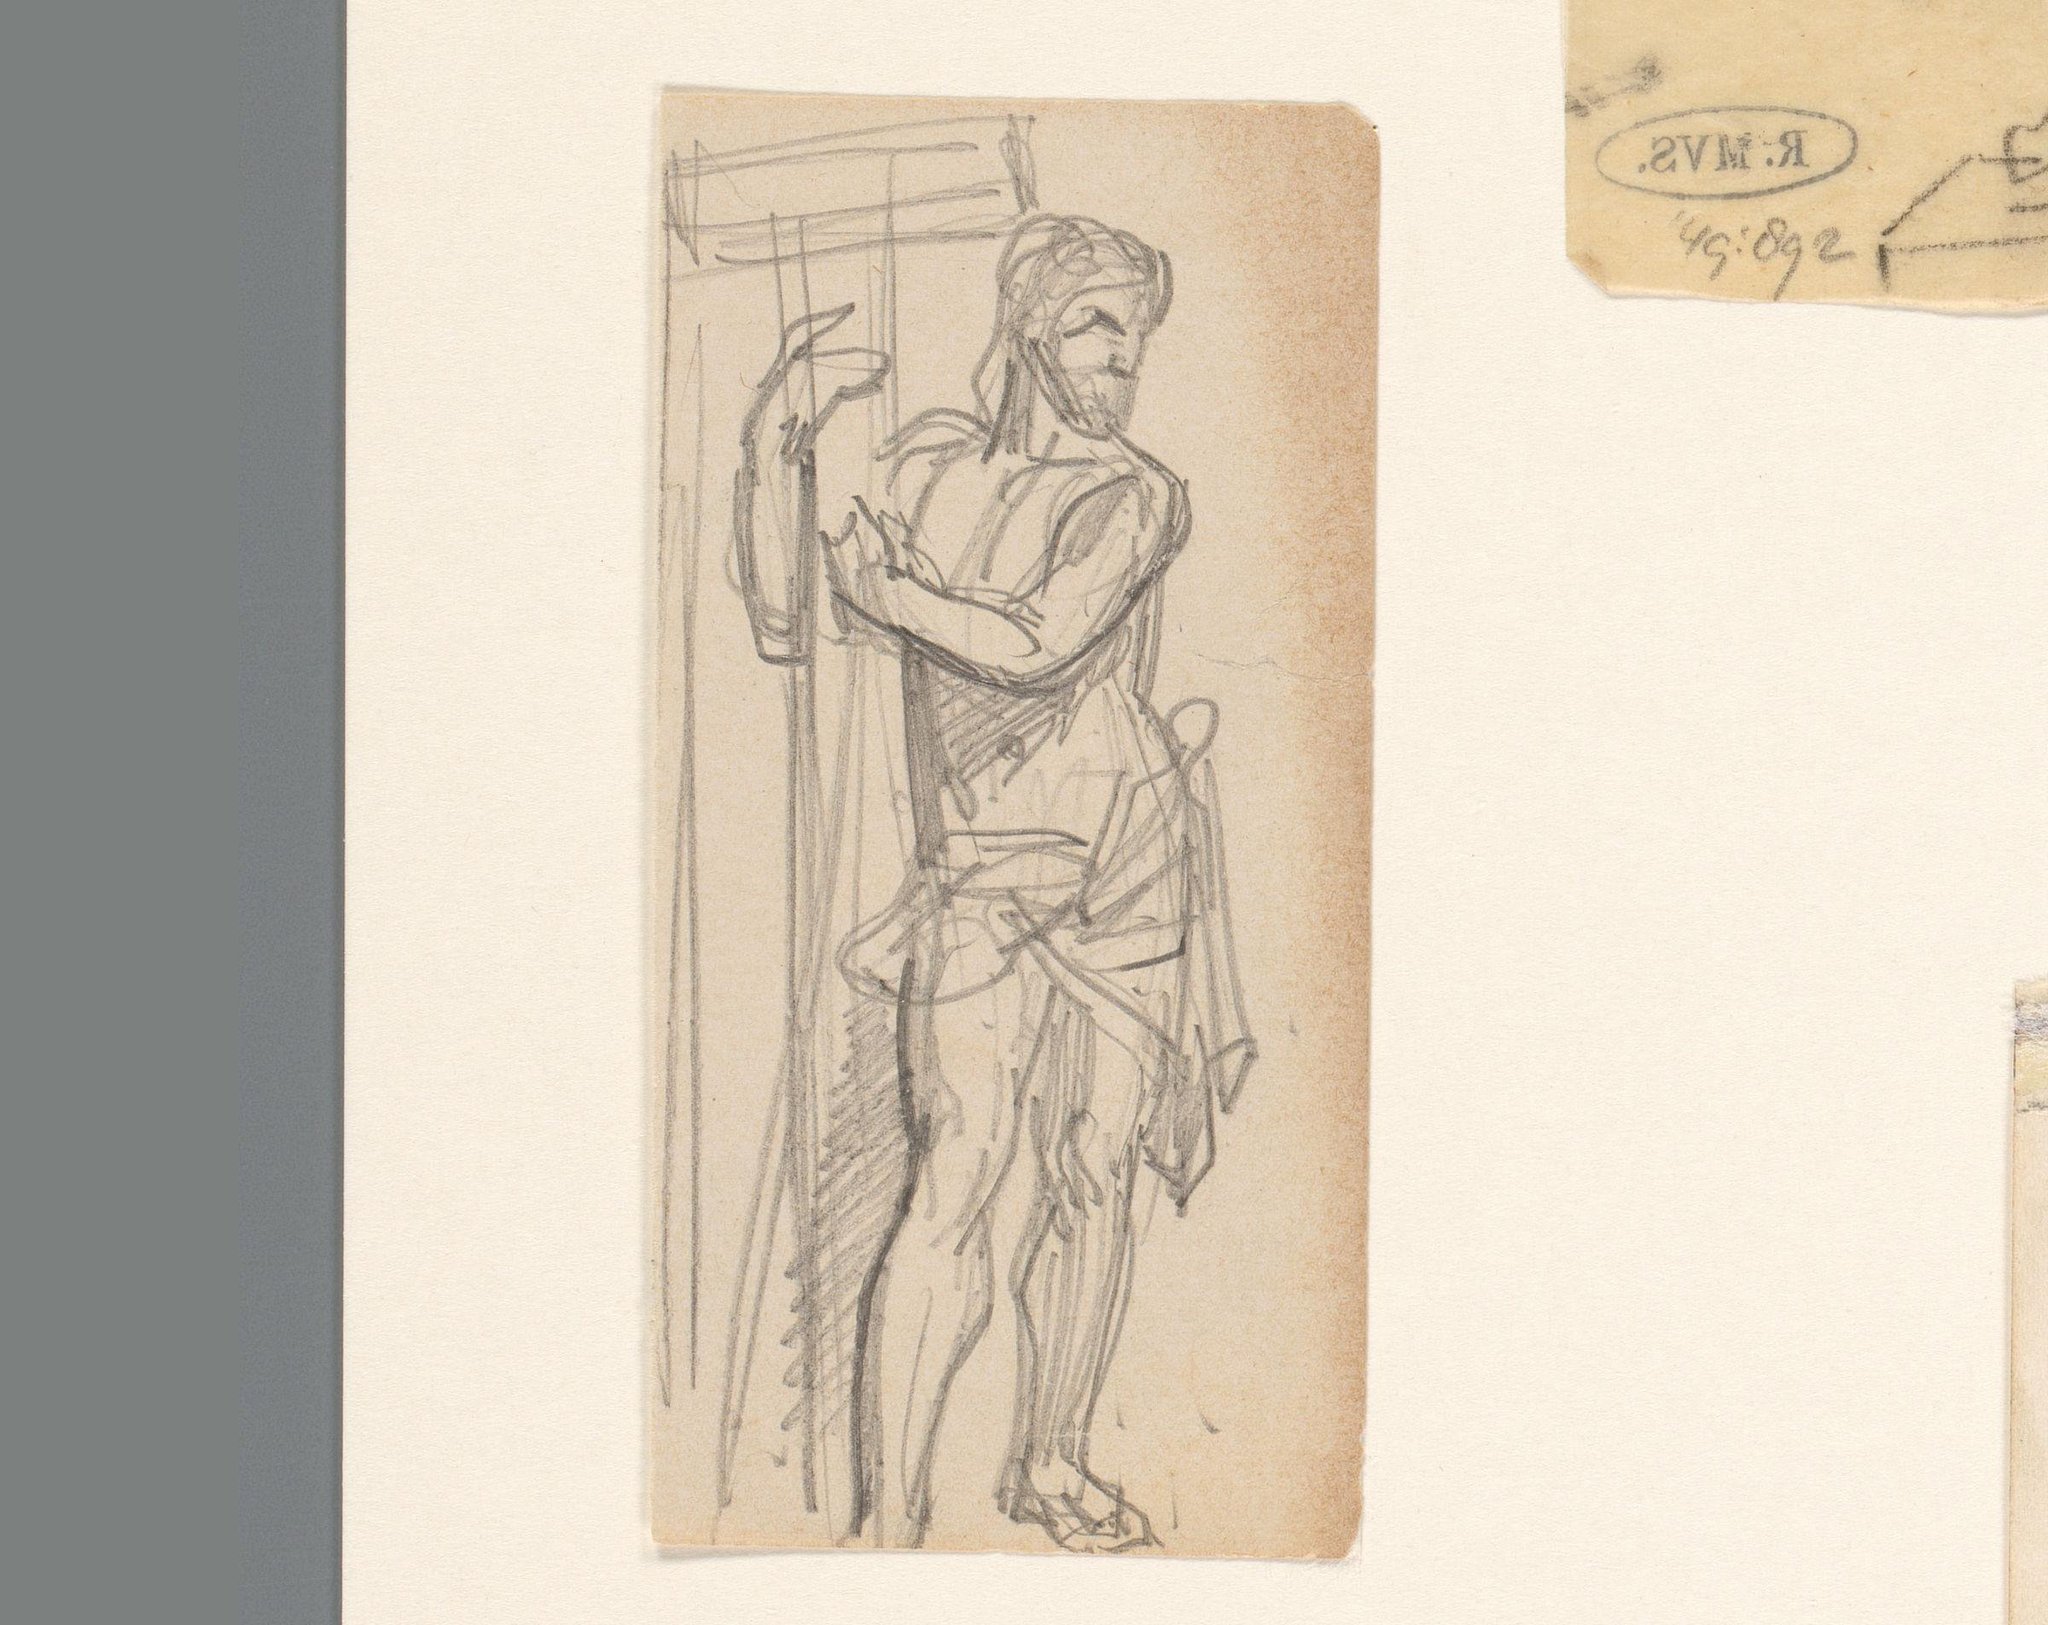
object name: drawing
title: Christus met kruis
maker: august allebé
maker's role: draughtsman, print maker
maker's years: 1838-1927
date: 1848-1927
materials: paper, pencil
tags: piece of sculpture, reproduction of a piece of sculpture